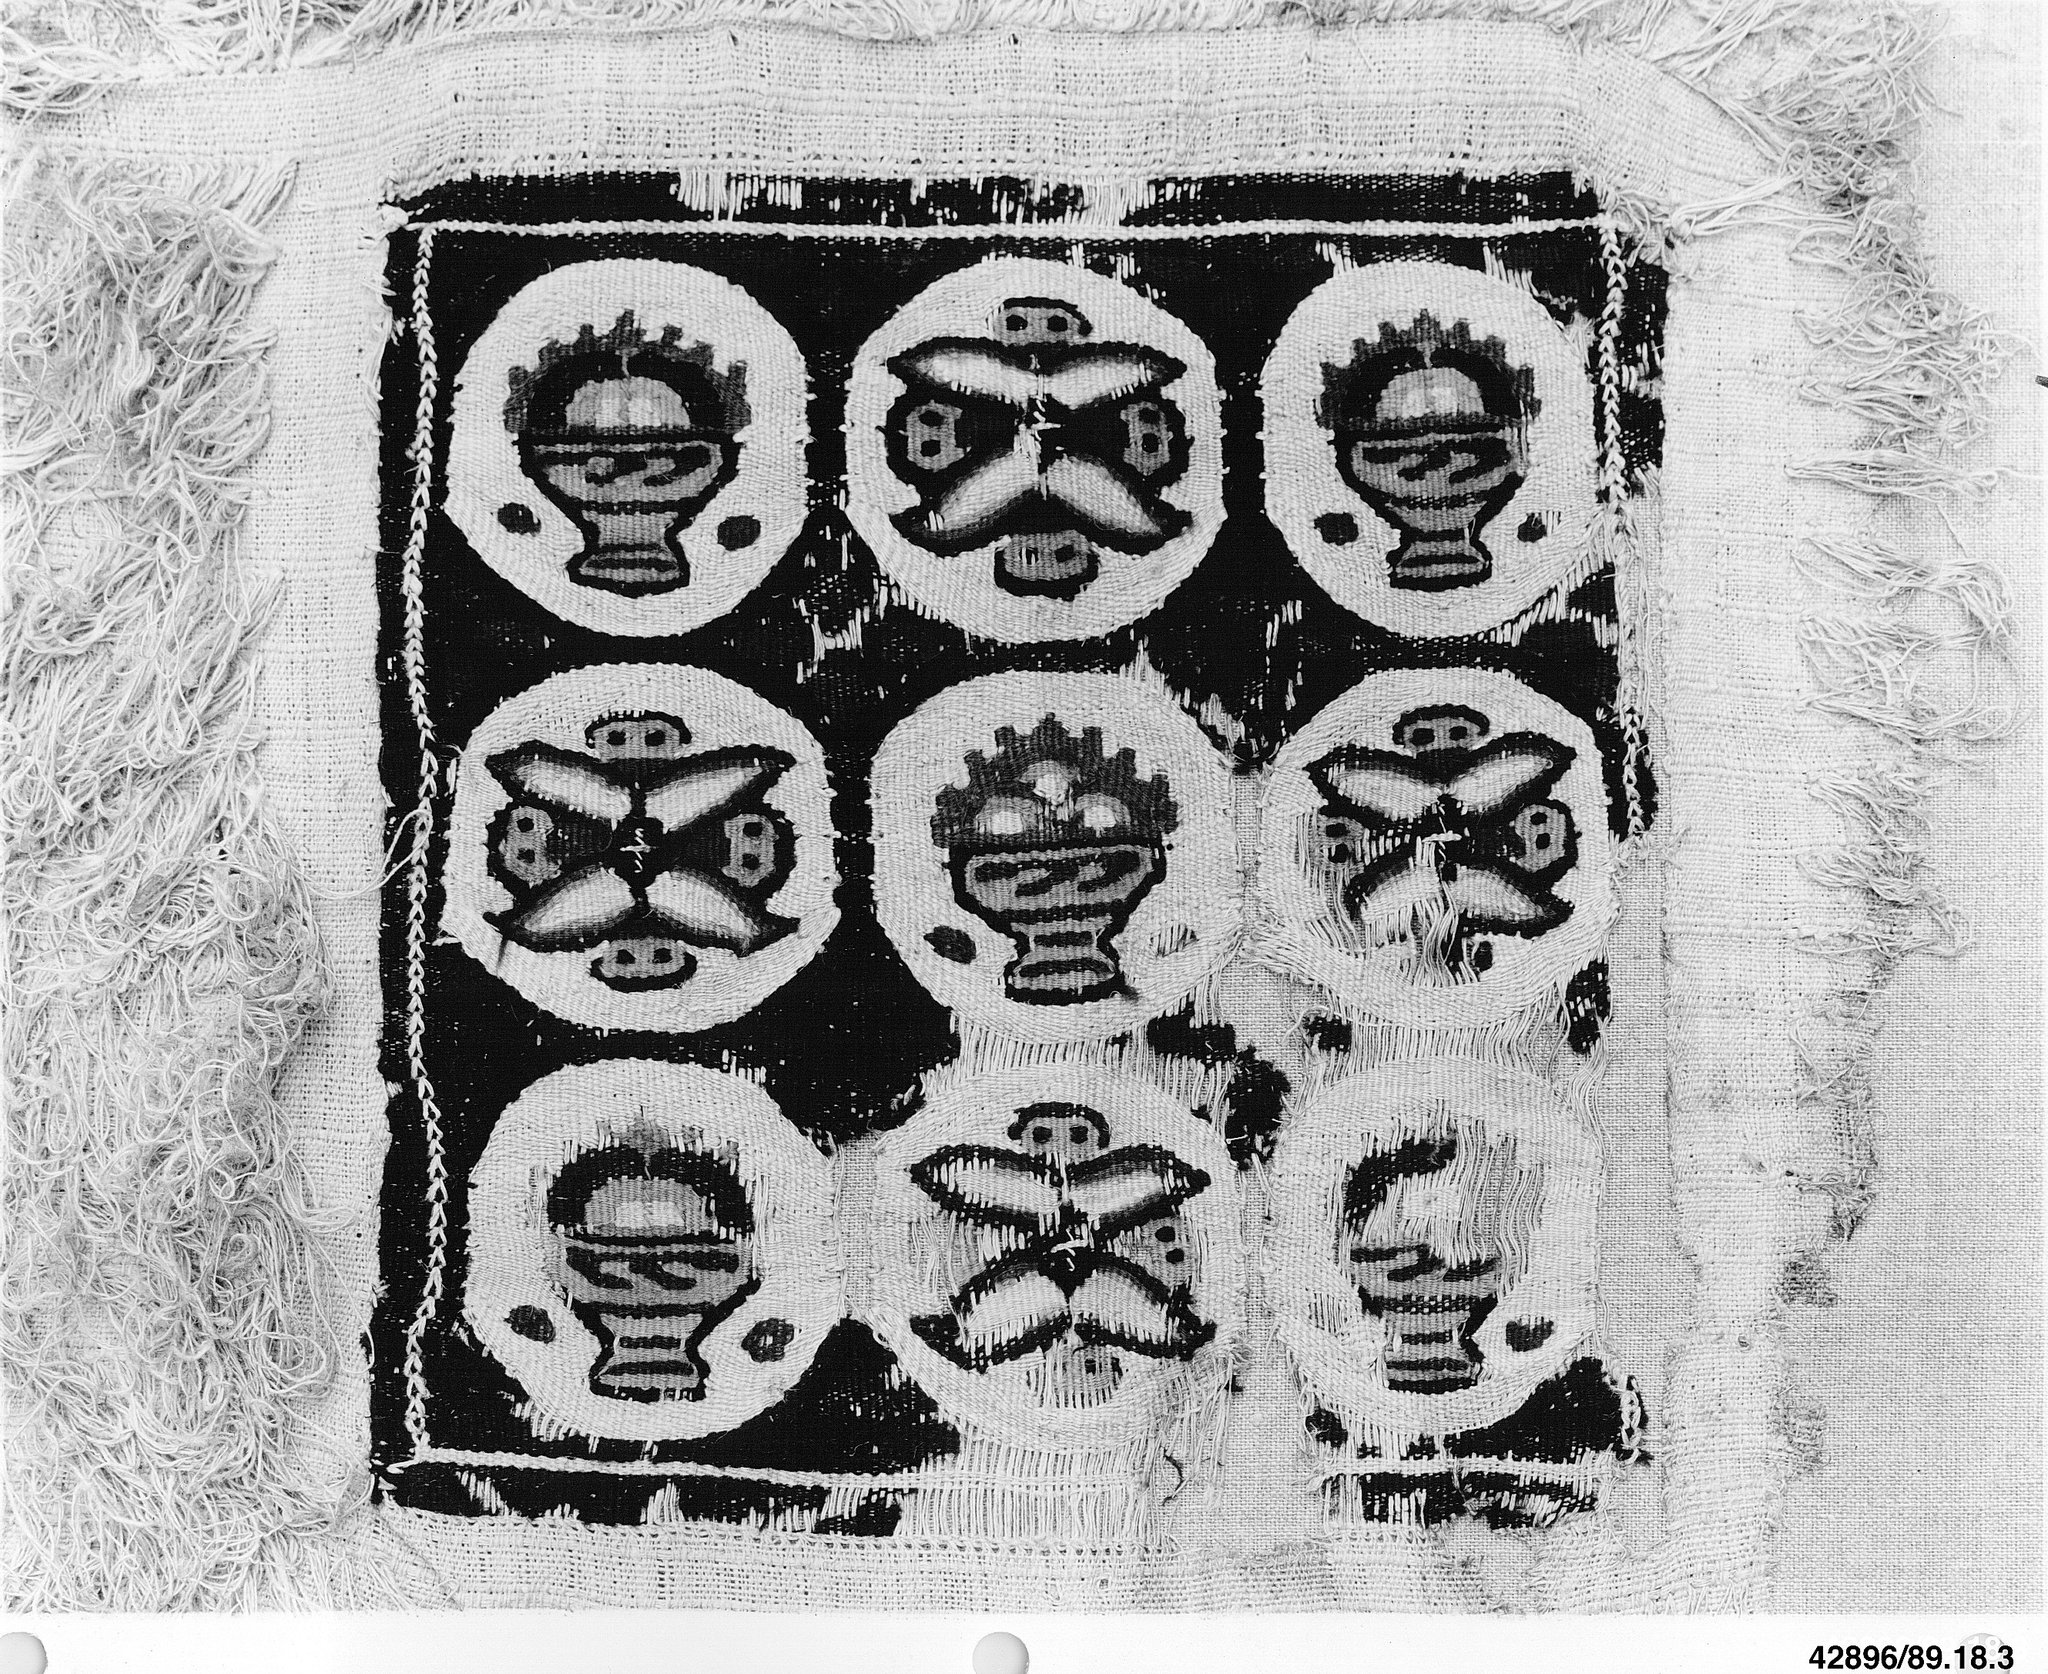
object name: textile fragment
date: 301-500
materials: linen, wool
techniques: weave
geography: egypt